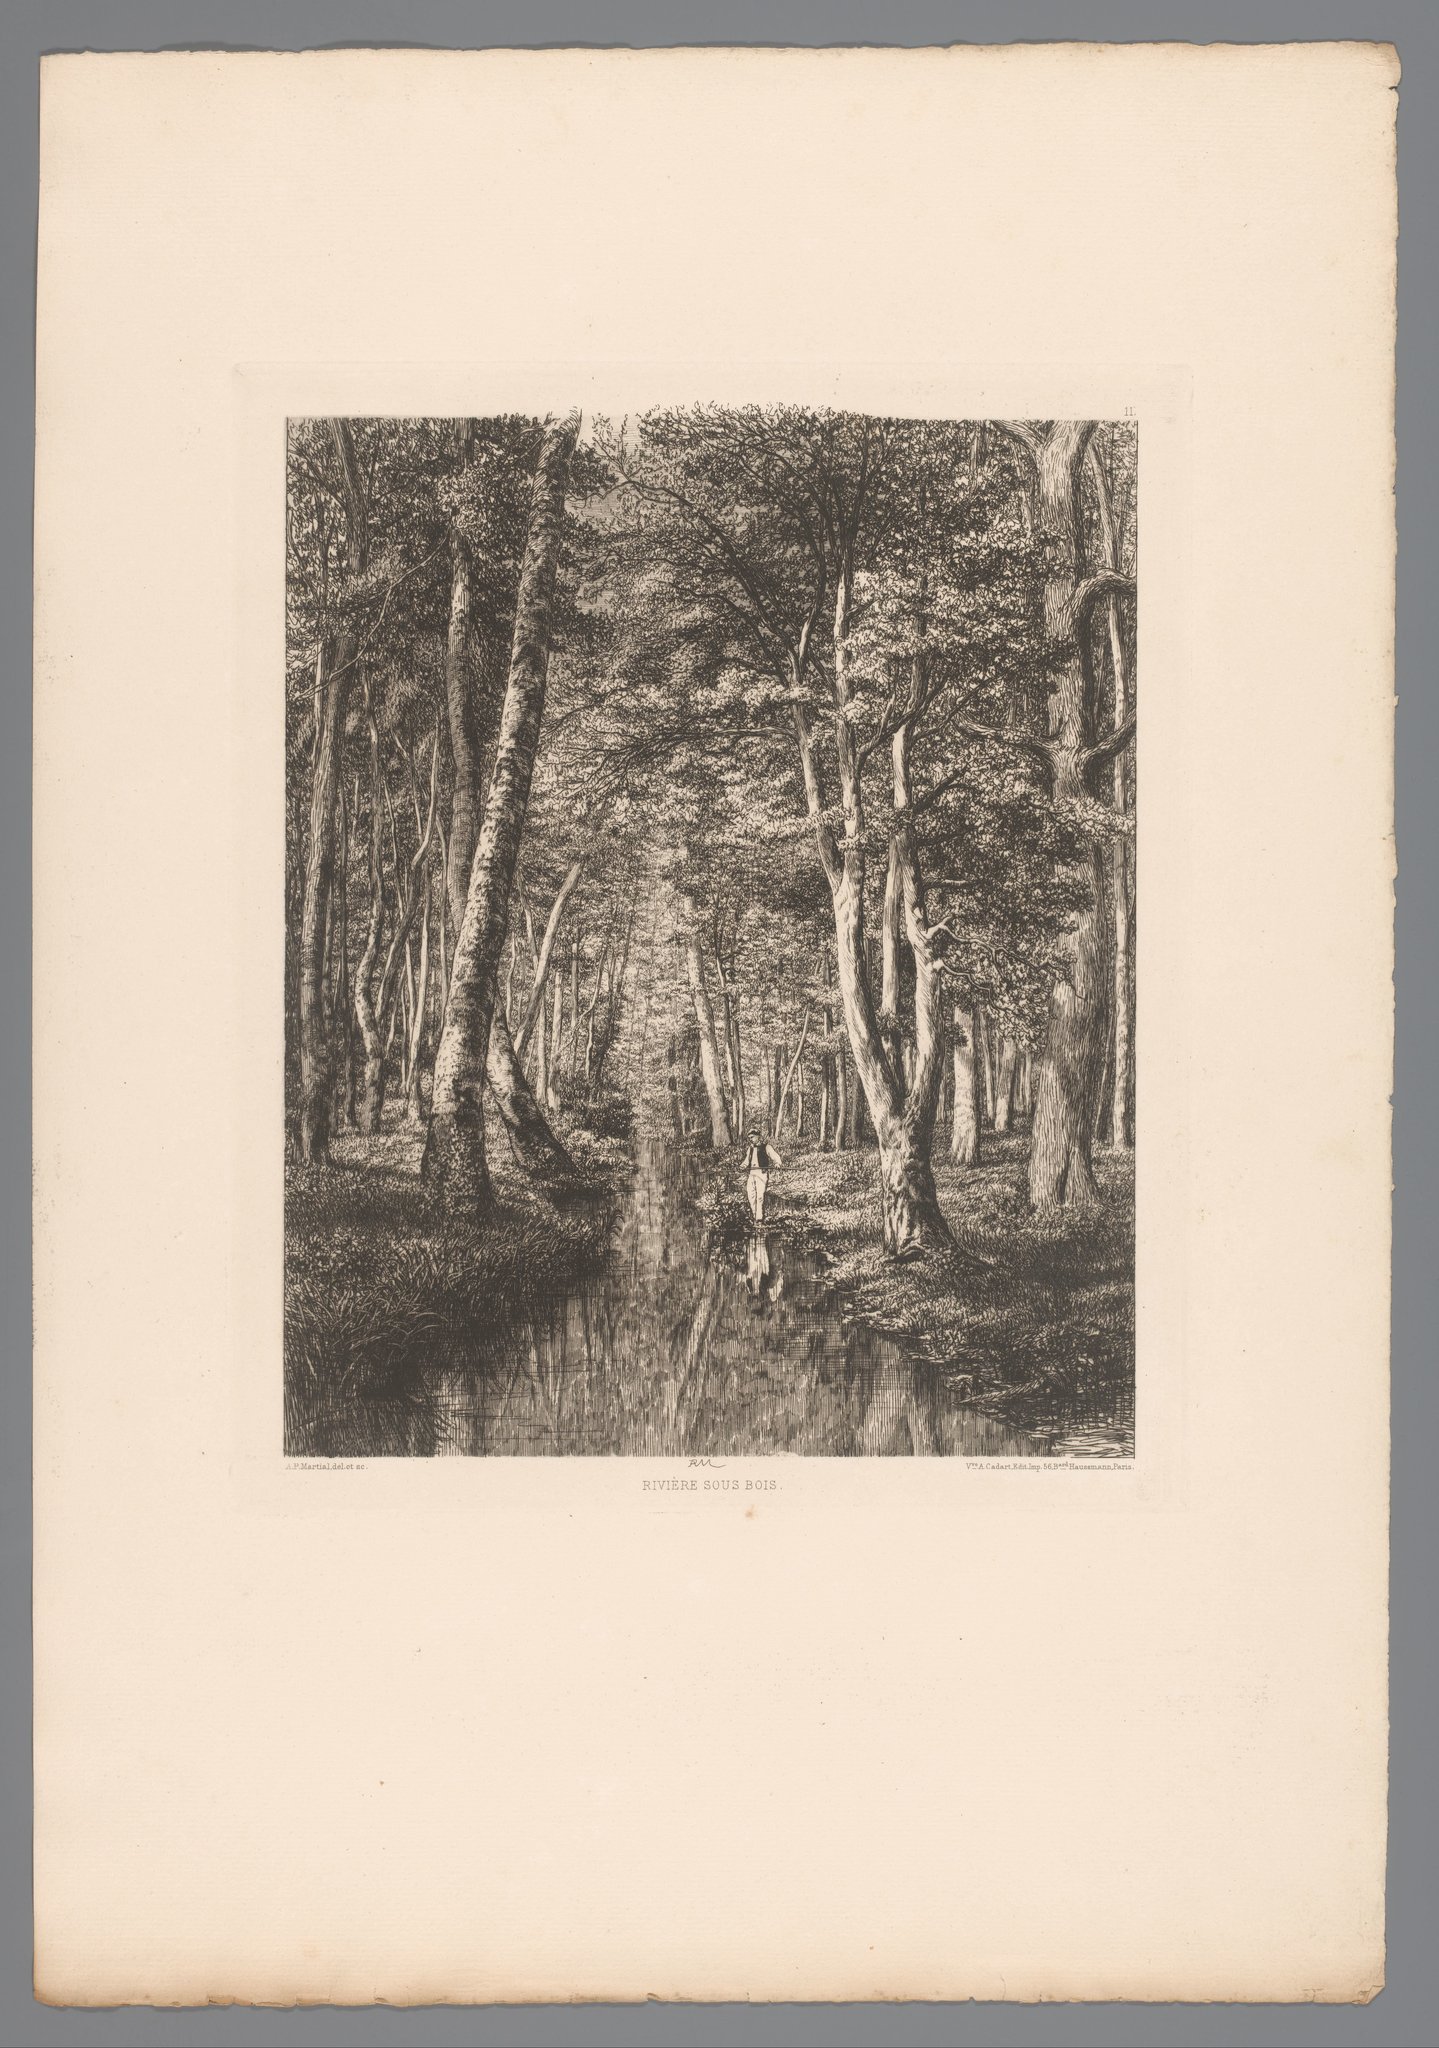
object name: print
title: Franse etsen uit 1879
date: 1879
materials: paper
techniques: drypoint, etching, intaglio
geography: paris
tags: forest, wood, angling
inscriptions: collector's mark: ‘AFE v S’, collector's mark: Lugt 2760, collector's mark: Lugt 2228